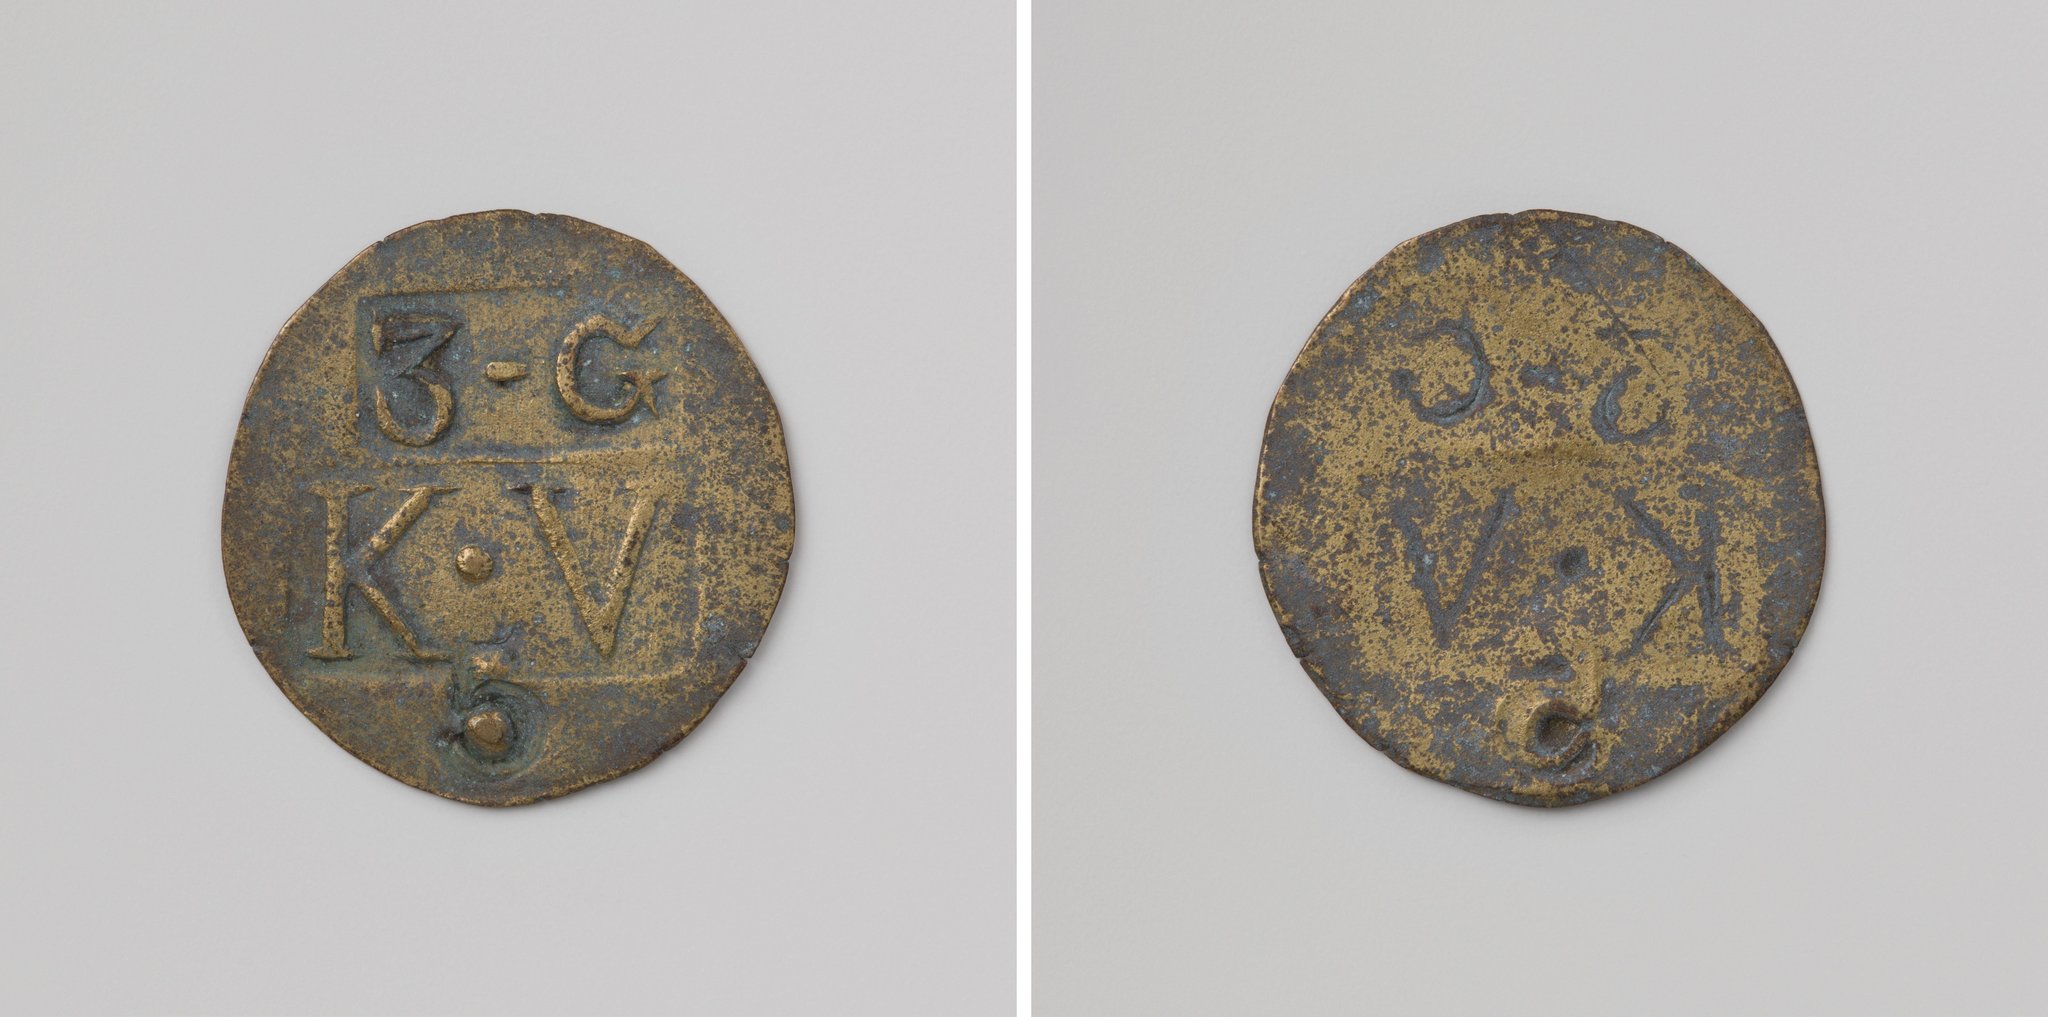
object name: monetary token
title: Derde gesticht van de kolonie Veenhuizen, huismunt geslagen op last van de Maatschappij van Weldadigheid ter waarde van vijf cent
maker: Anonymous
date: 1818-1859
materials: brass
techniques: striking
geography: netherlands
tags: maatschappij van weldadigheid, veenhuizen